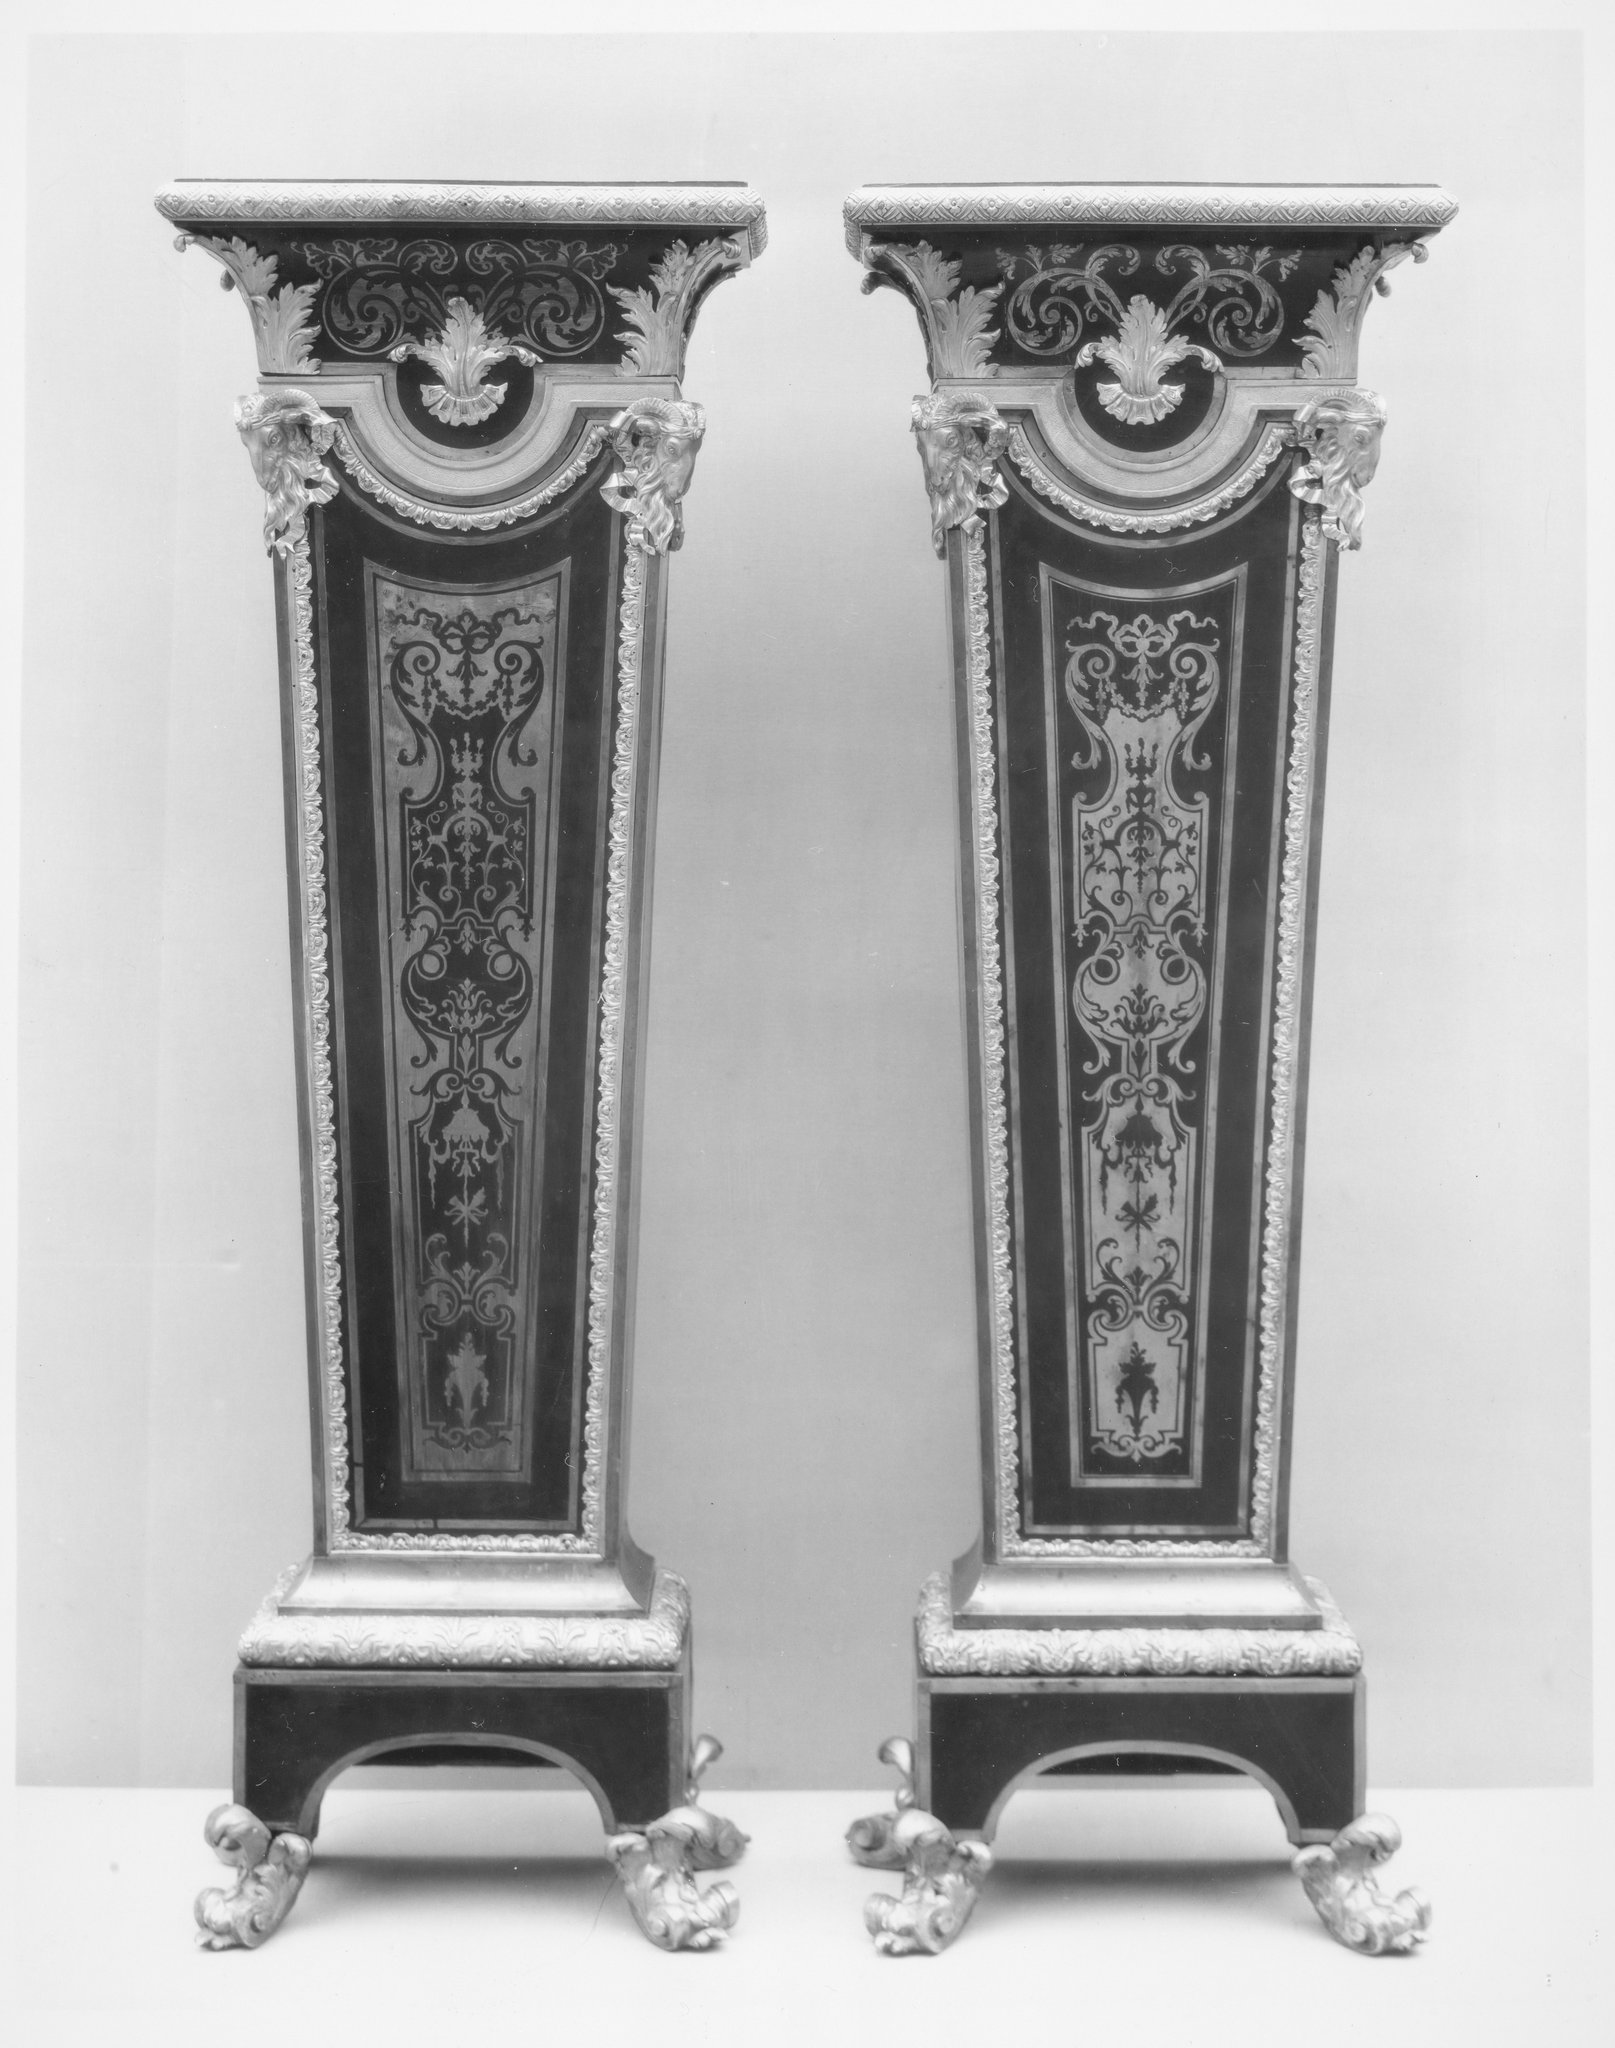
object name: pedestal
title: Pair of pedestals (gaînes)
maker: andré charles boulle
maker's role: maker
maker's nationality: french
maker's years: 1642-1732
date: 1701-1800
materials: brass, wood, gilt bronze